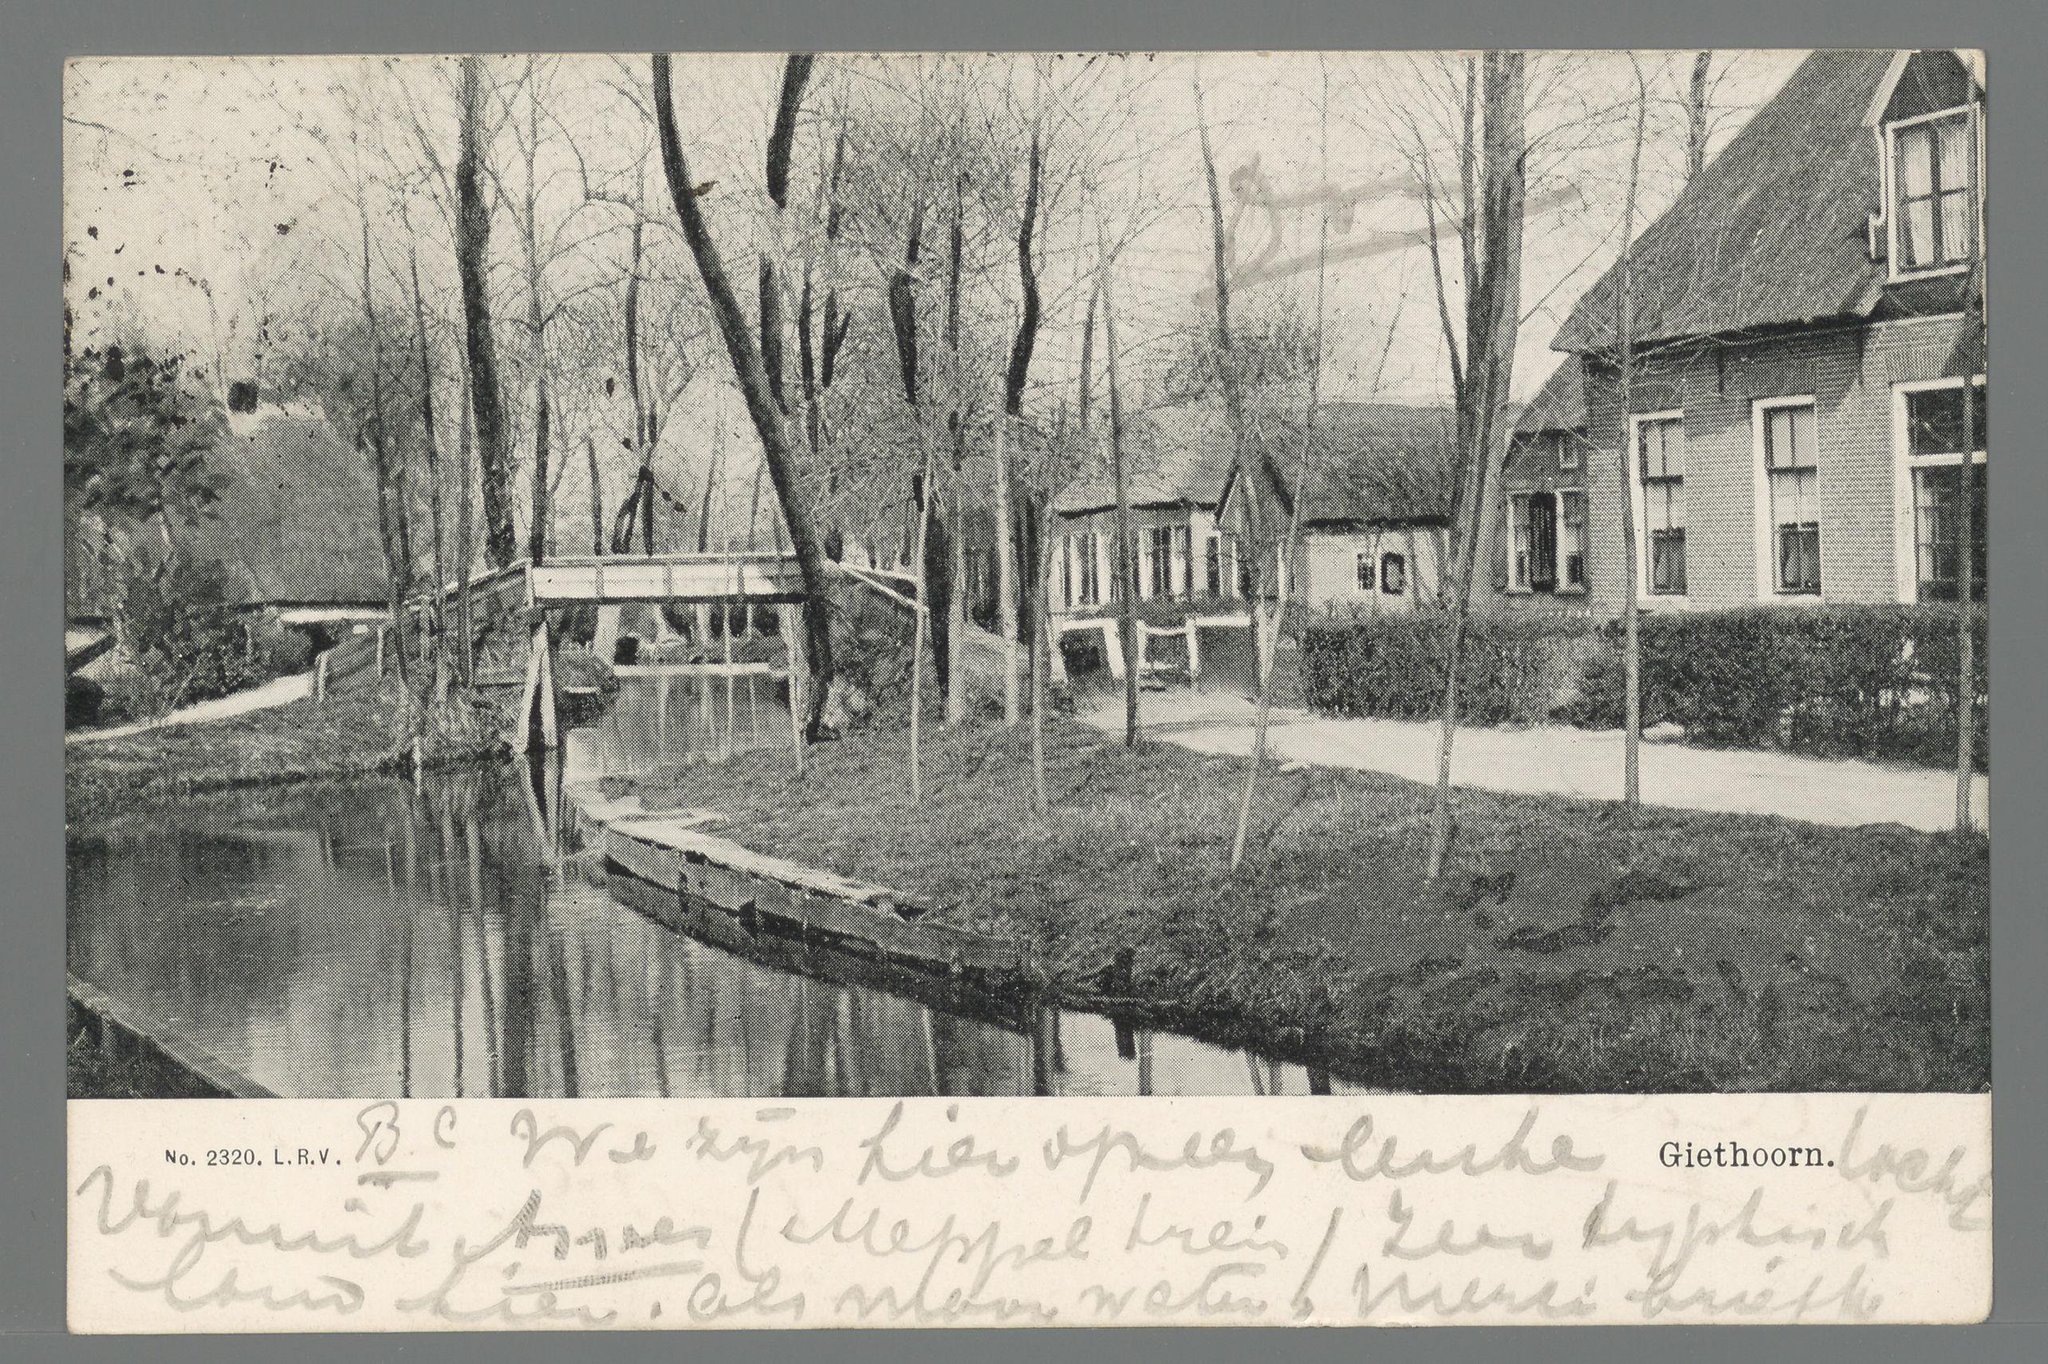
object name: ansichtkaart, prentbriefkaart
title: Giethoorn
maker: Anonymous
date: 1897-1905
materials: cardboard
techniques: writing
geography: zwolle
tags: canals, waters (in village), street, bridge in village across river, canal, etc.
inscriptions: postage stamp